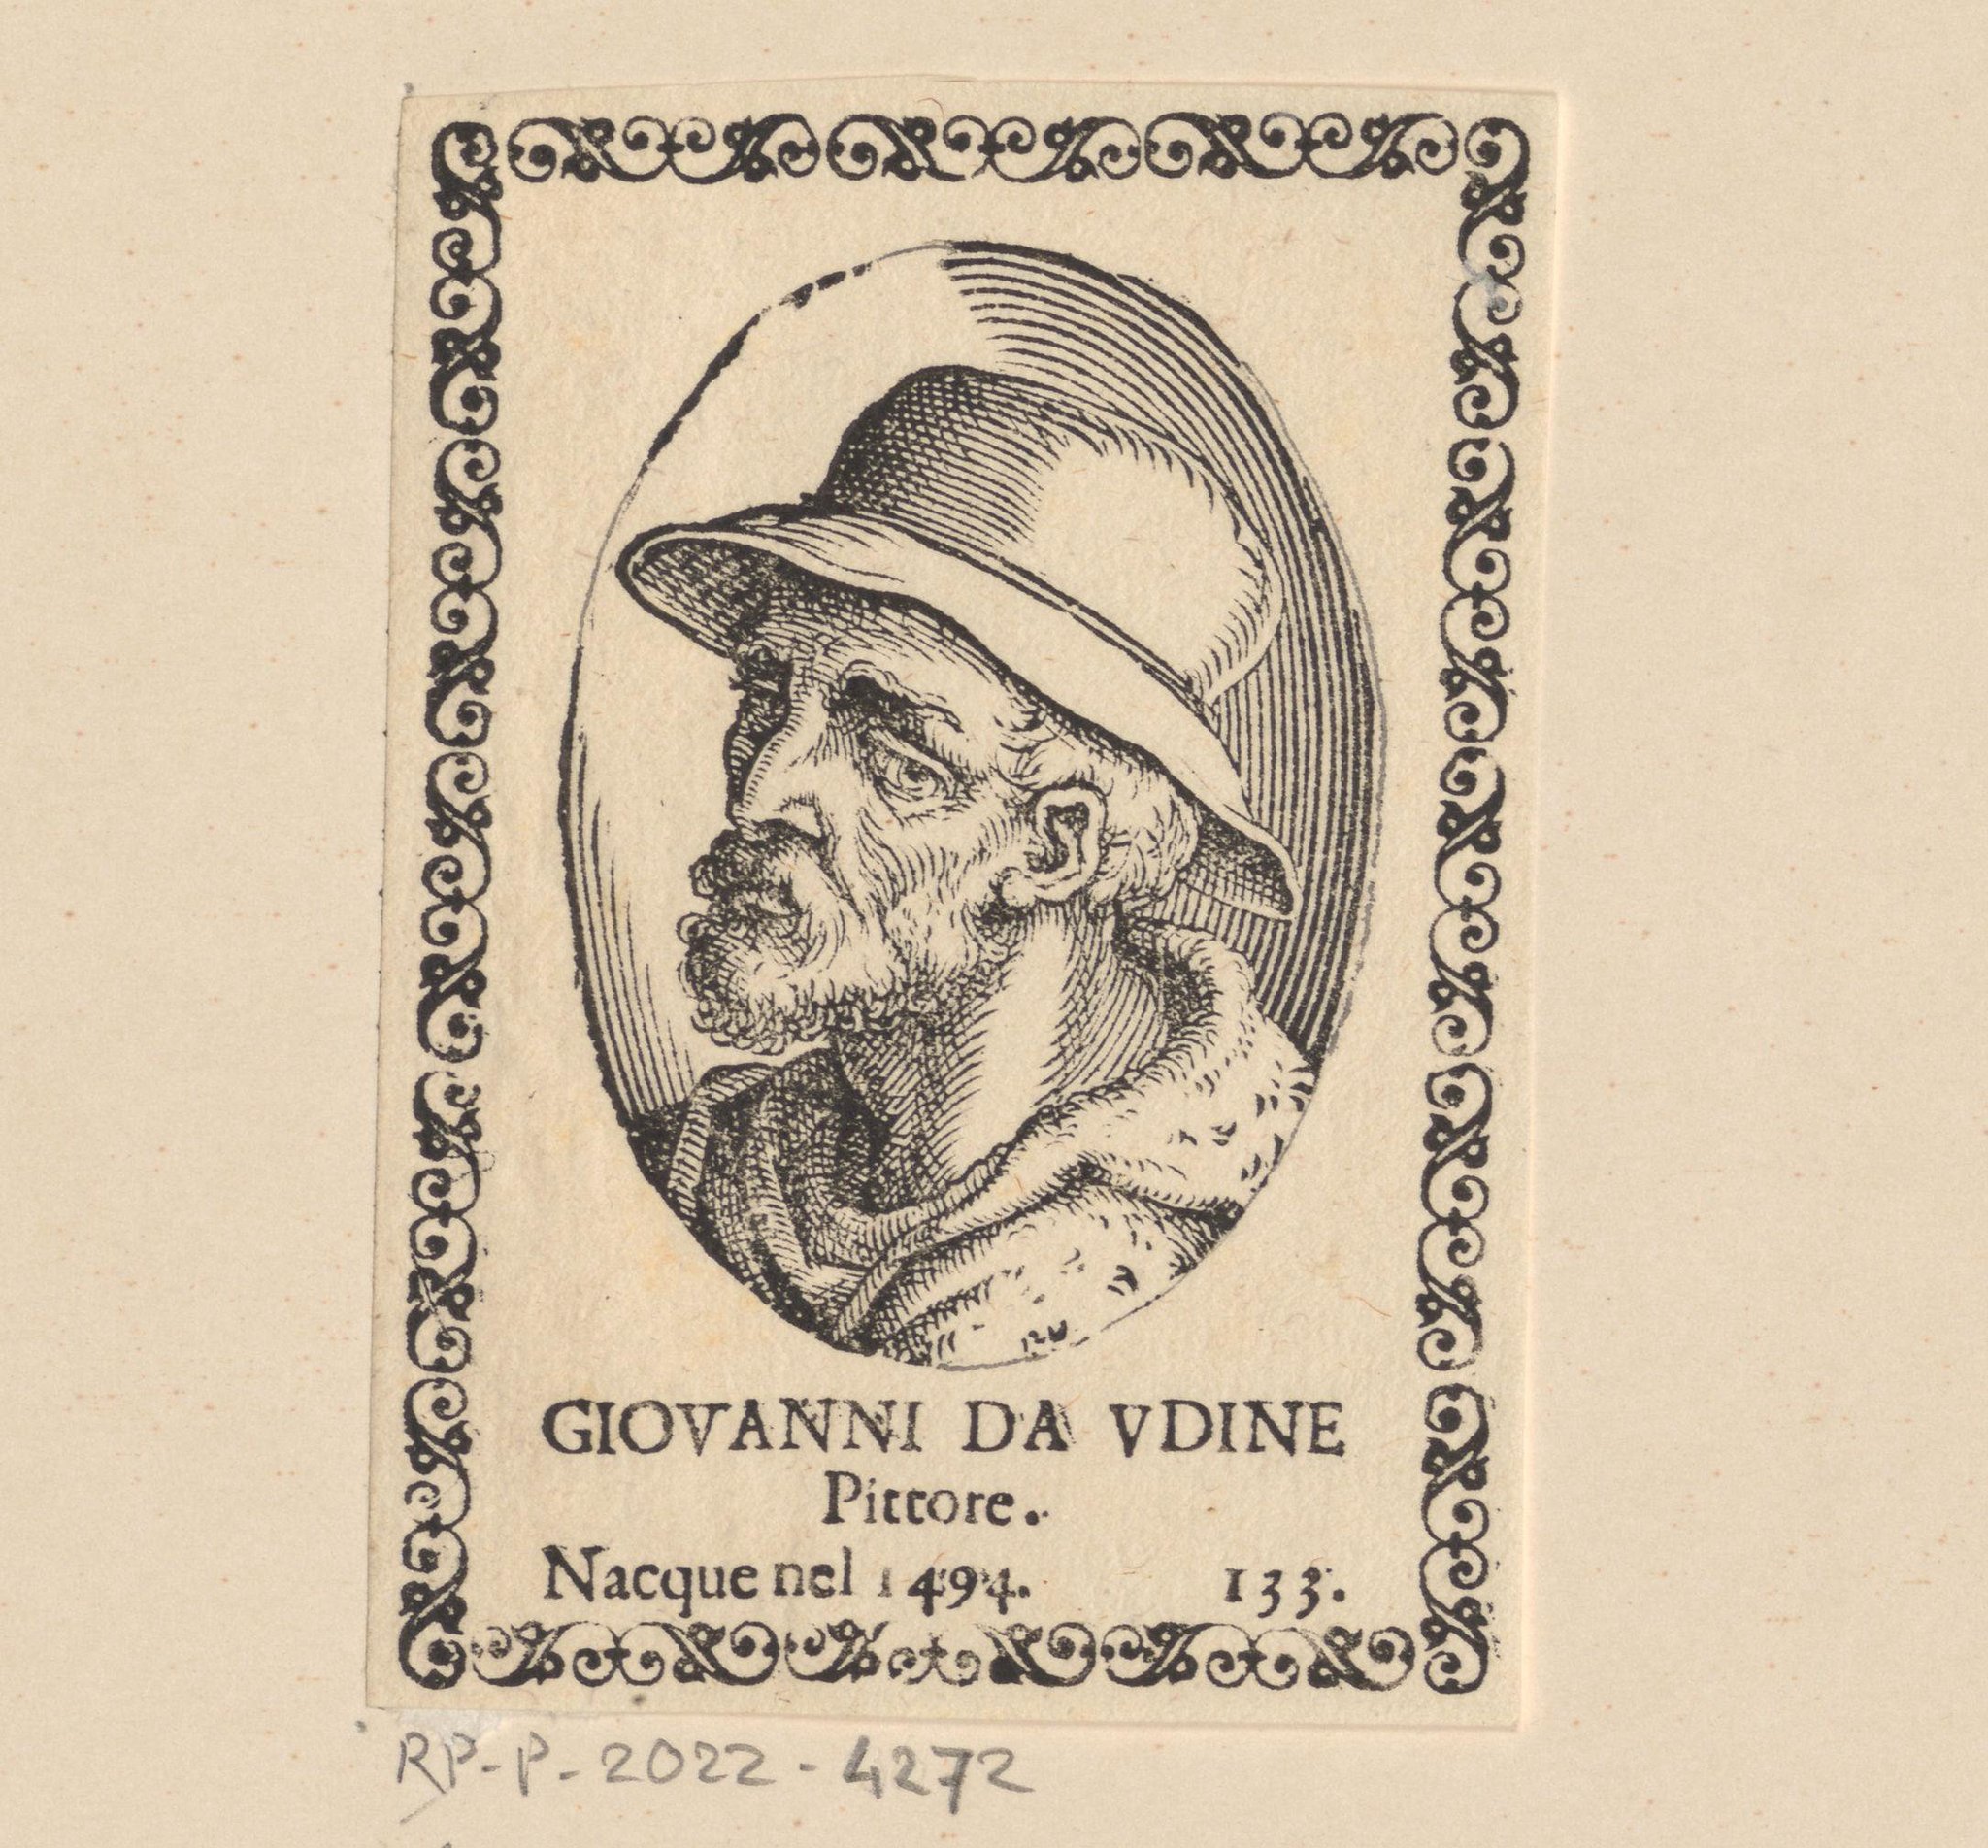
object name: print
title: Portret van Giovanni da Udine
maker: cristoforo coriolano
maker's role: print maker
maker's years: 1540-1610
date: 1568-1650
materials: paper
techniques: woodcut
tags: rome, painter, sculptor, historical persons, portrait, self-portrait of painter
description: Prent komt uit een editie van Vasari's 'Vite'. Prent met een andere omlijsting is gebruikt in de editie uit 1568: Vasari, Giorgio. Le vite de' piu eccellenti pittori scultori, e architettori. Florence: Filippo Giunta, 1568. En mogelijk in de editie uit 1647.